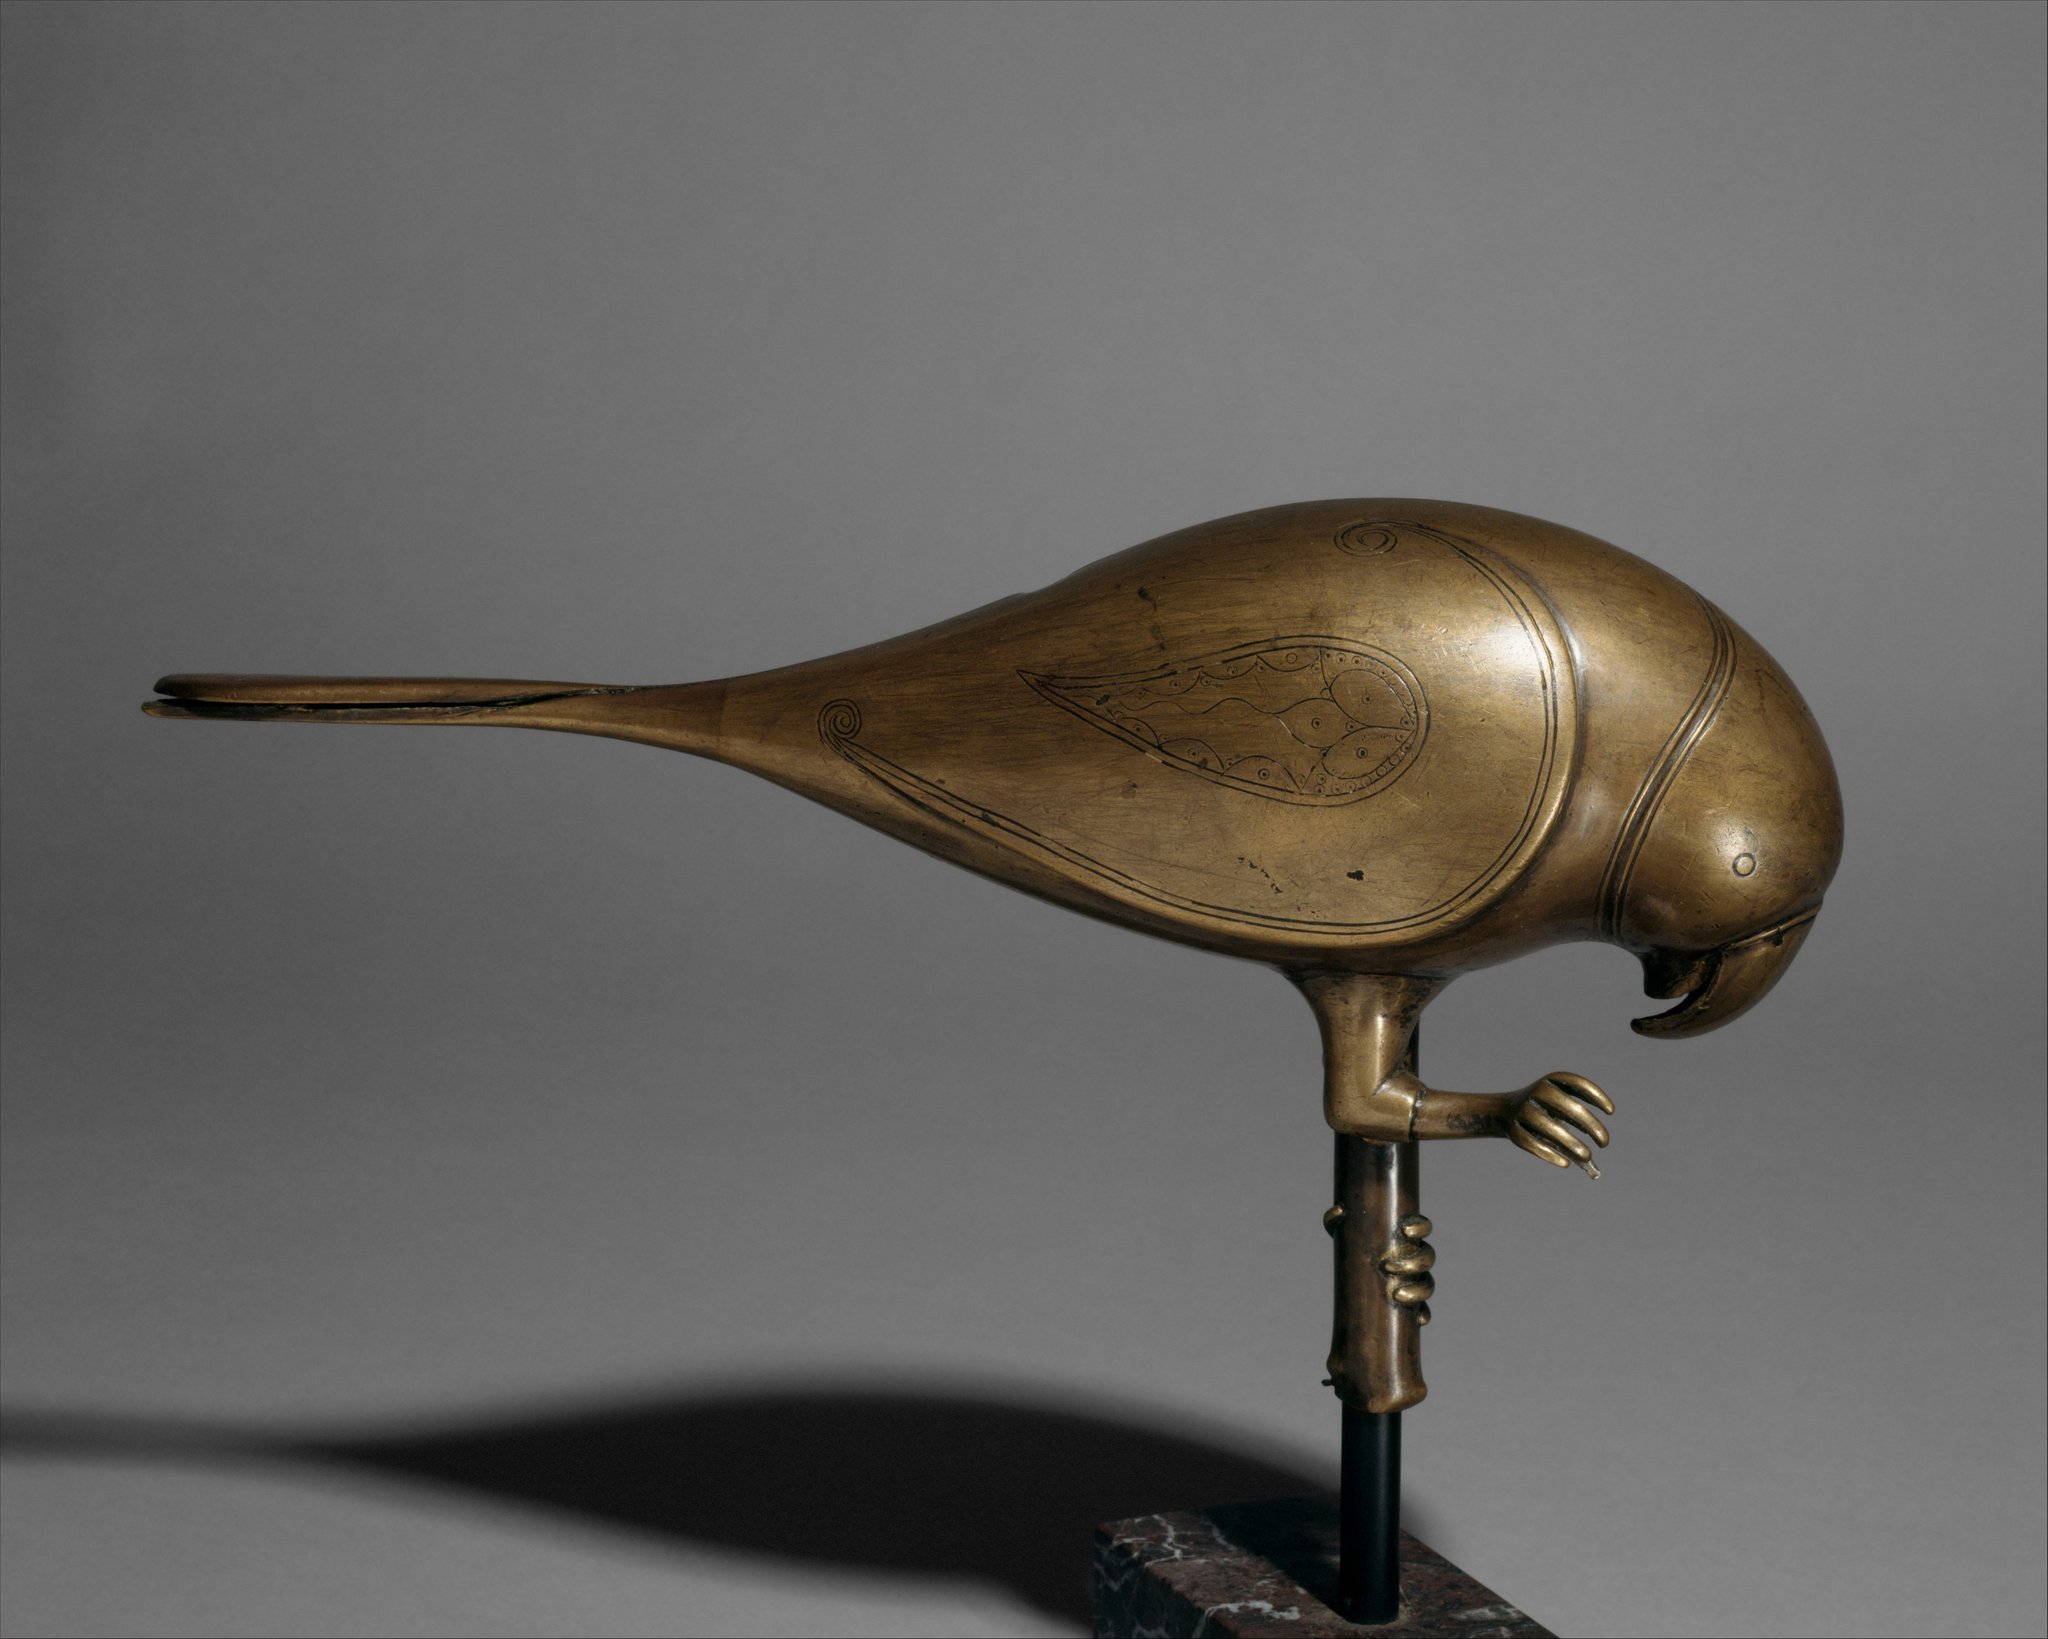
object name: finial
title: Finial in the Form of a Parrot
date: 1601-1800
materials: brass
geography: northern india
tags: parrots